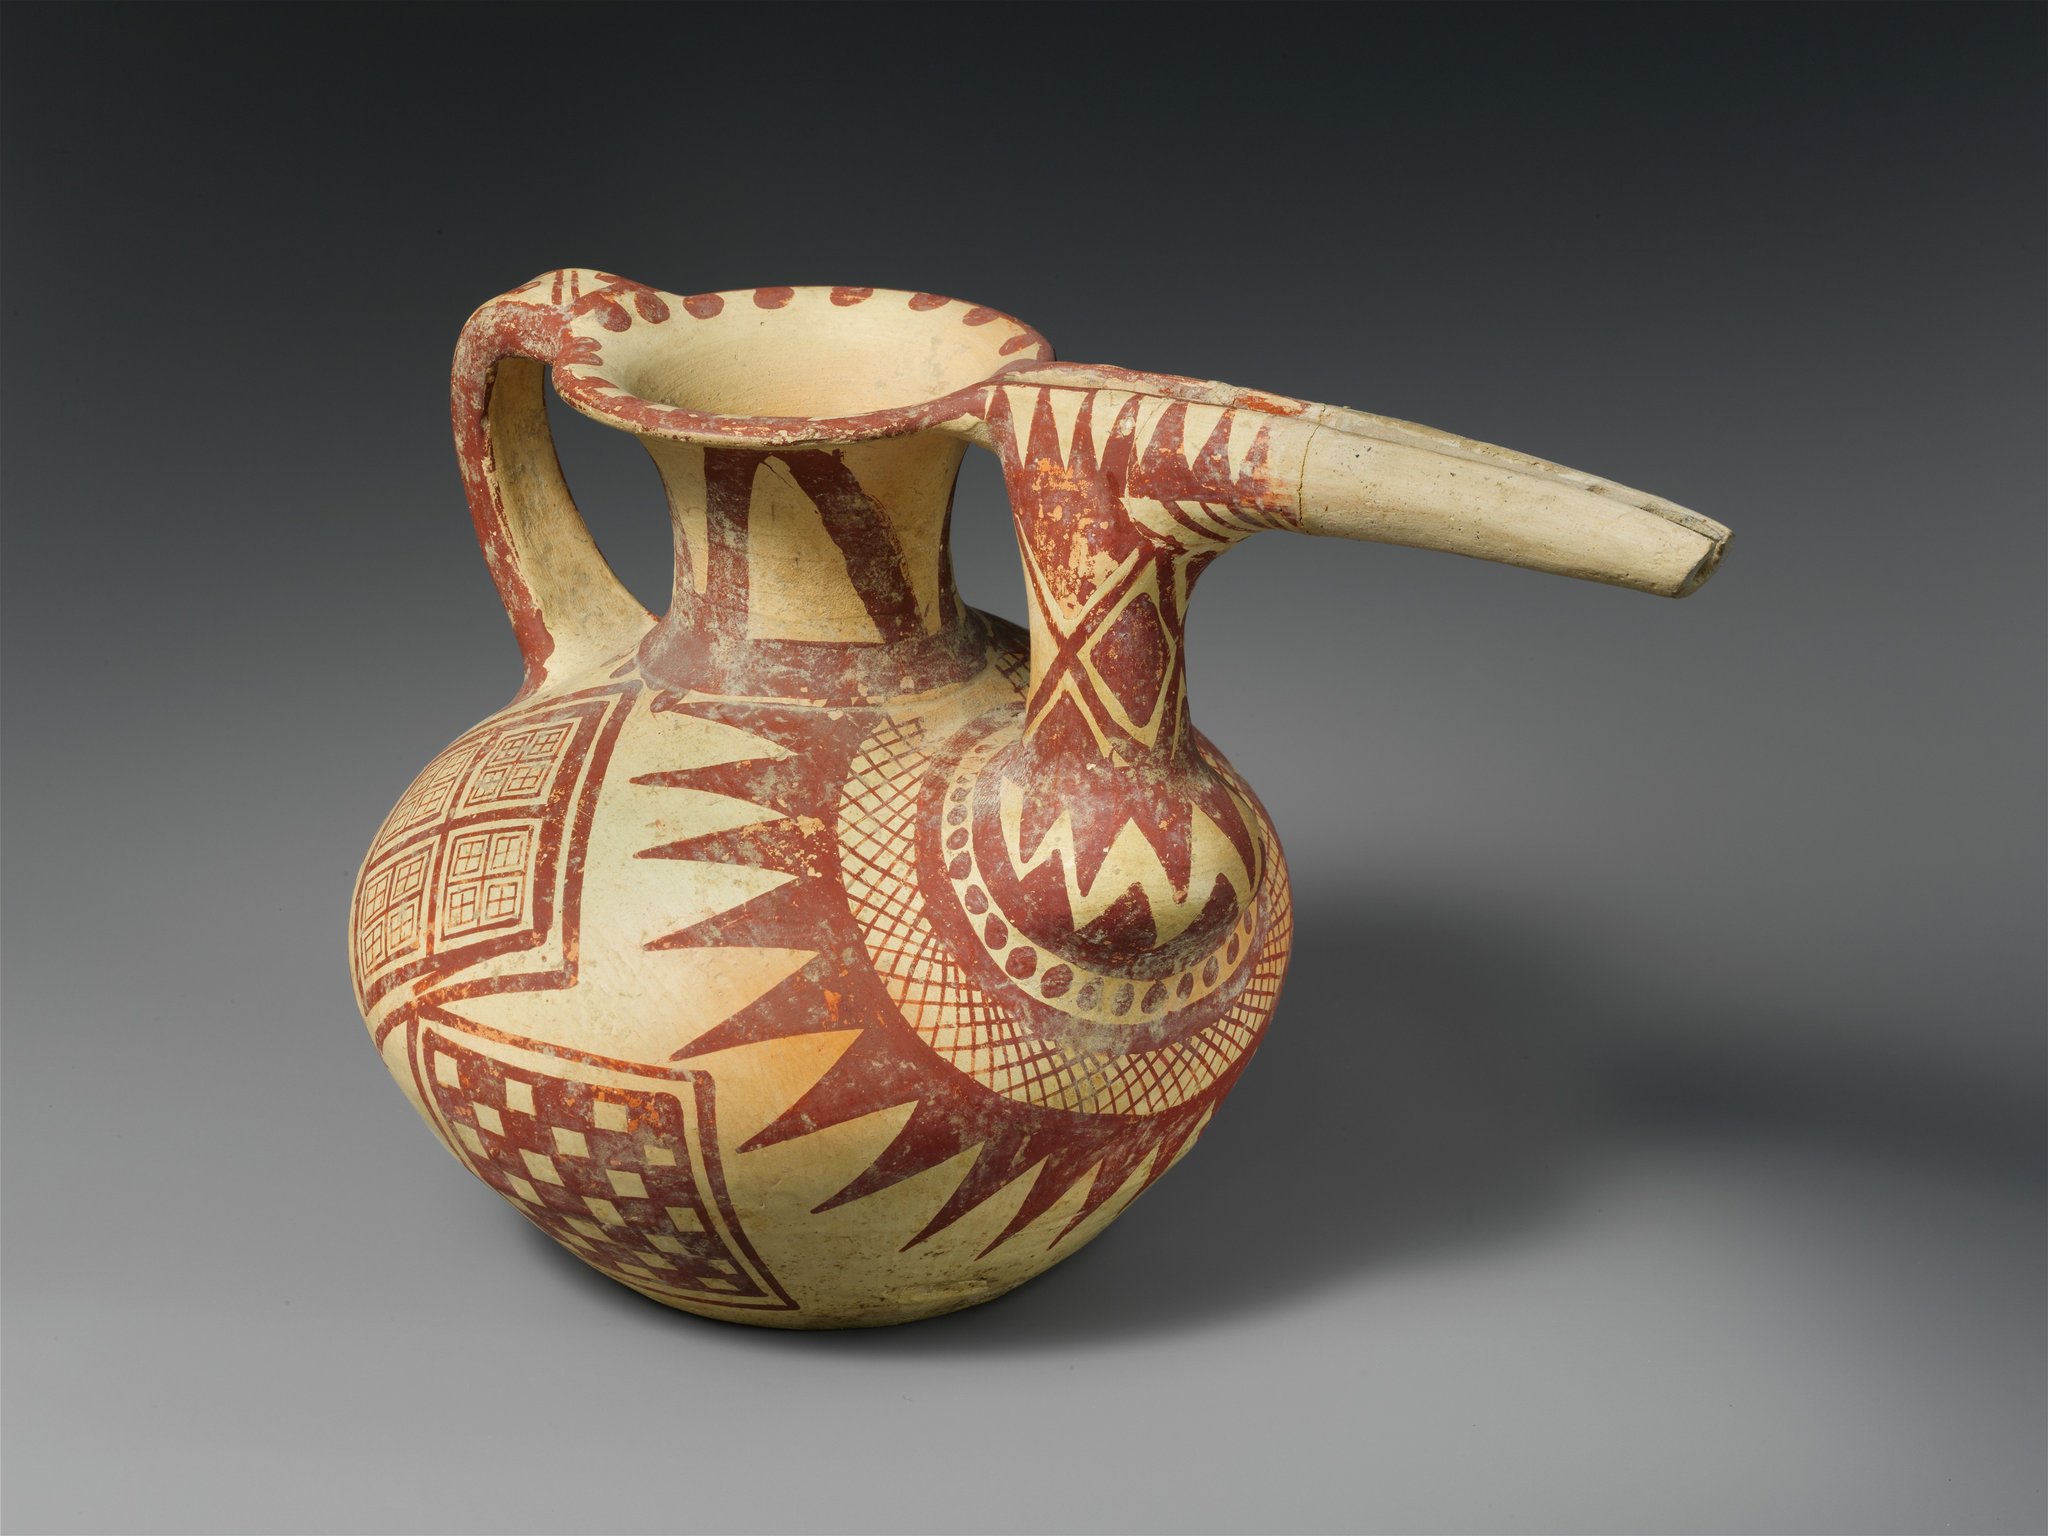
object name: jar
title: Spouted jar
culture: iranian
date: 900-601 BCE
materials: ceramic, paint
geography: iran